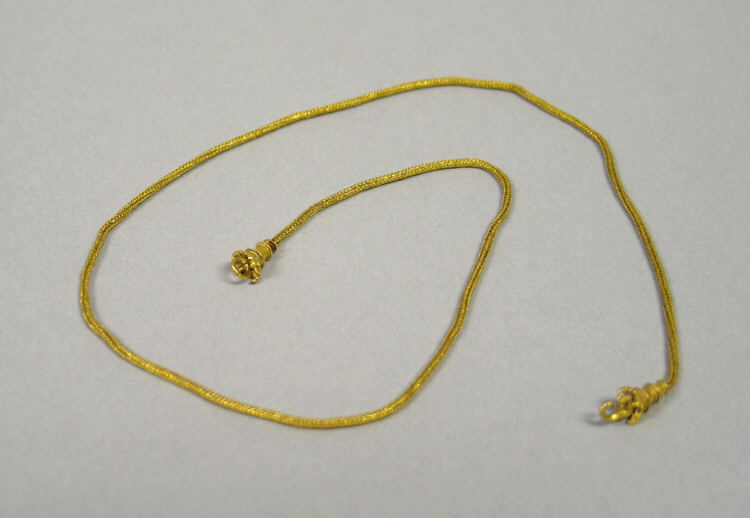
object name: chain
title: Braided Wire Chain with Clasp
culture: indonesian, javanese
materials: gold